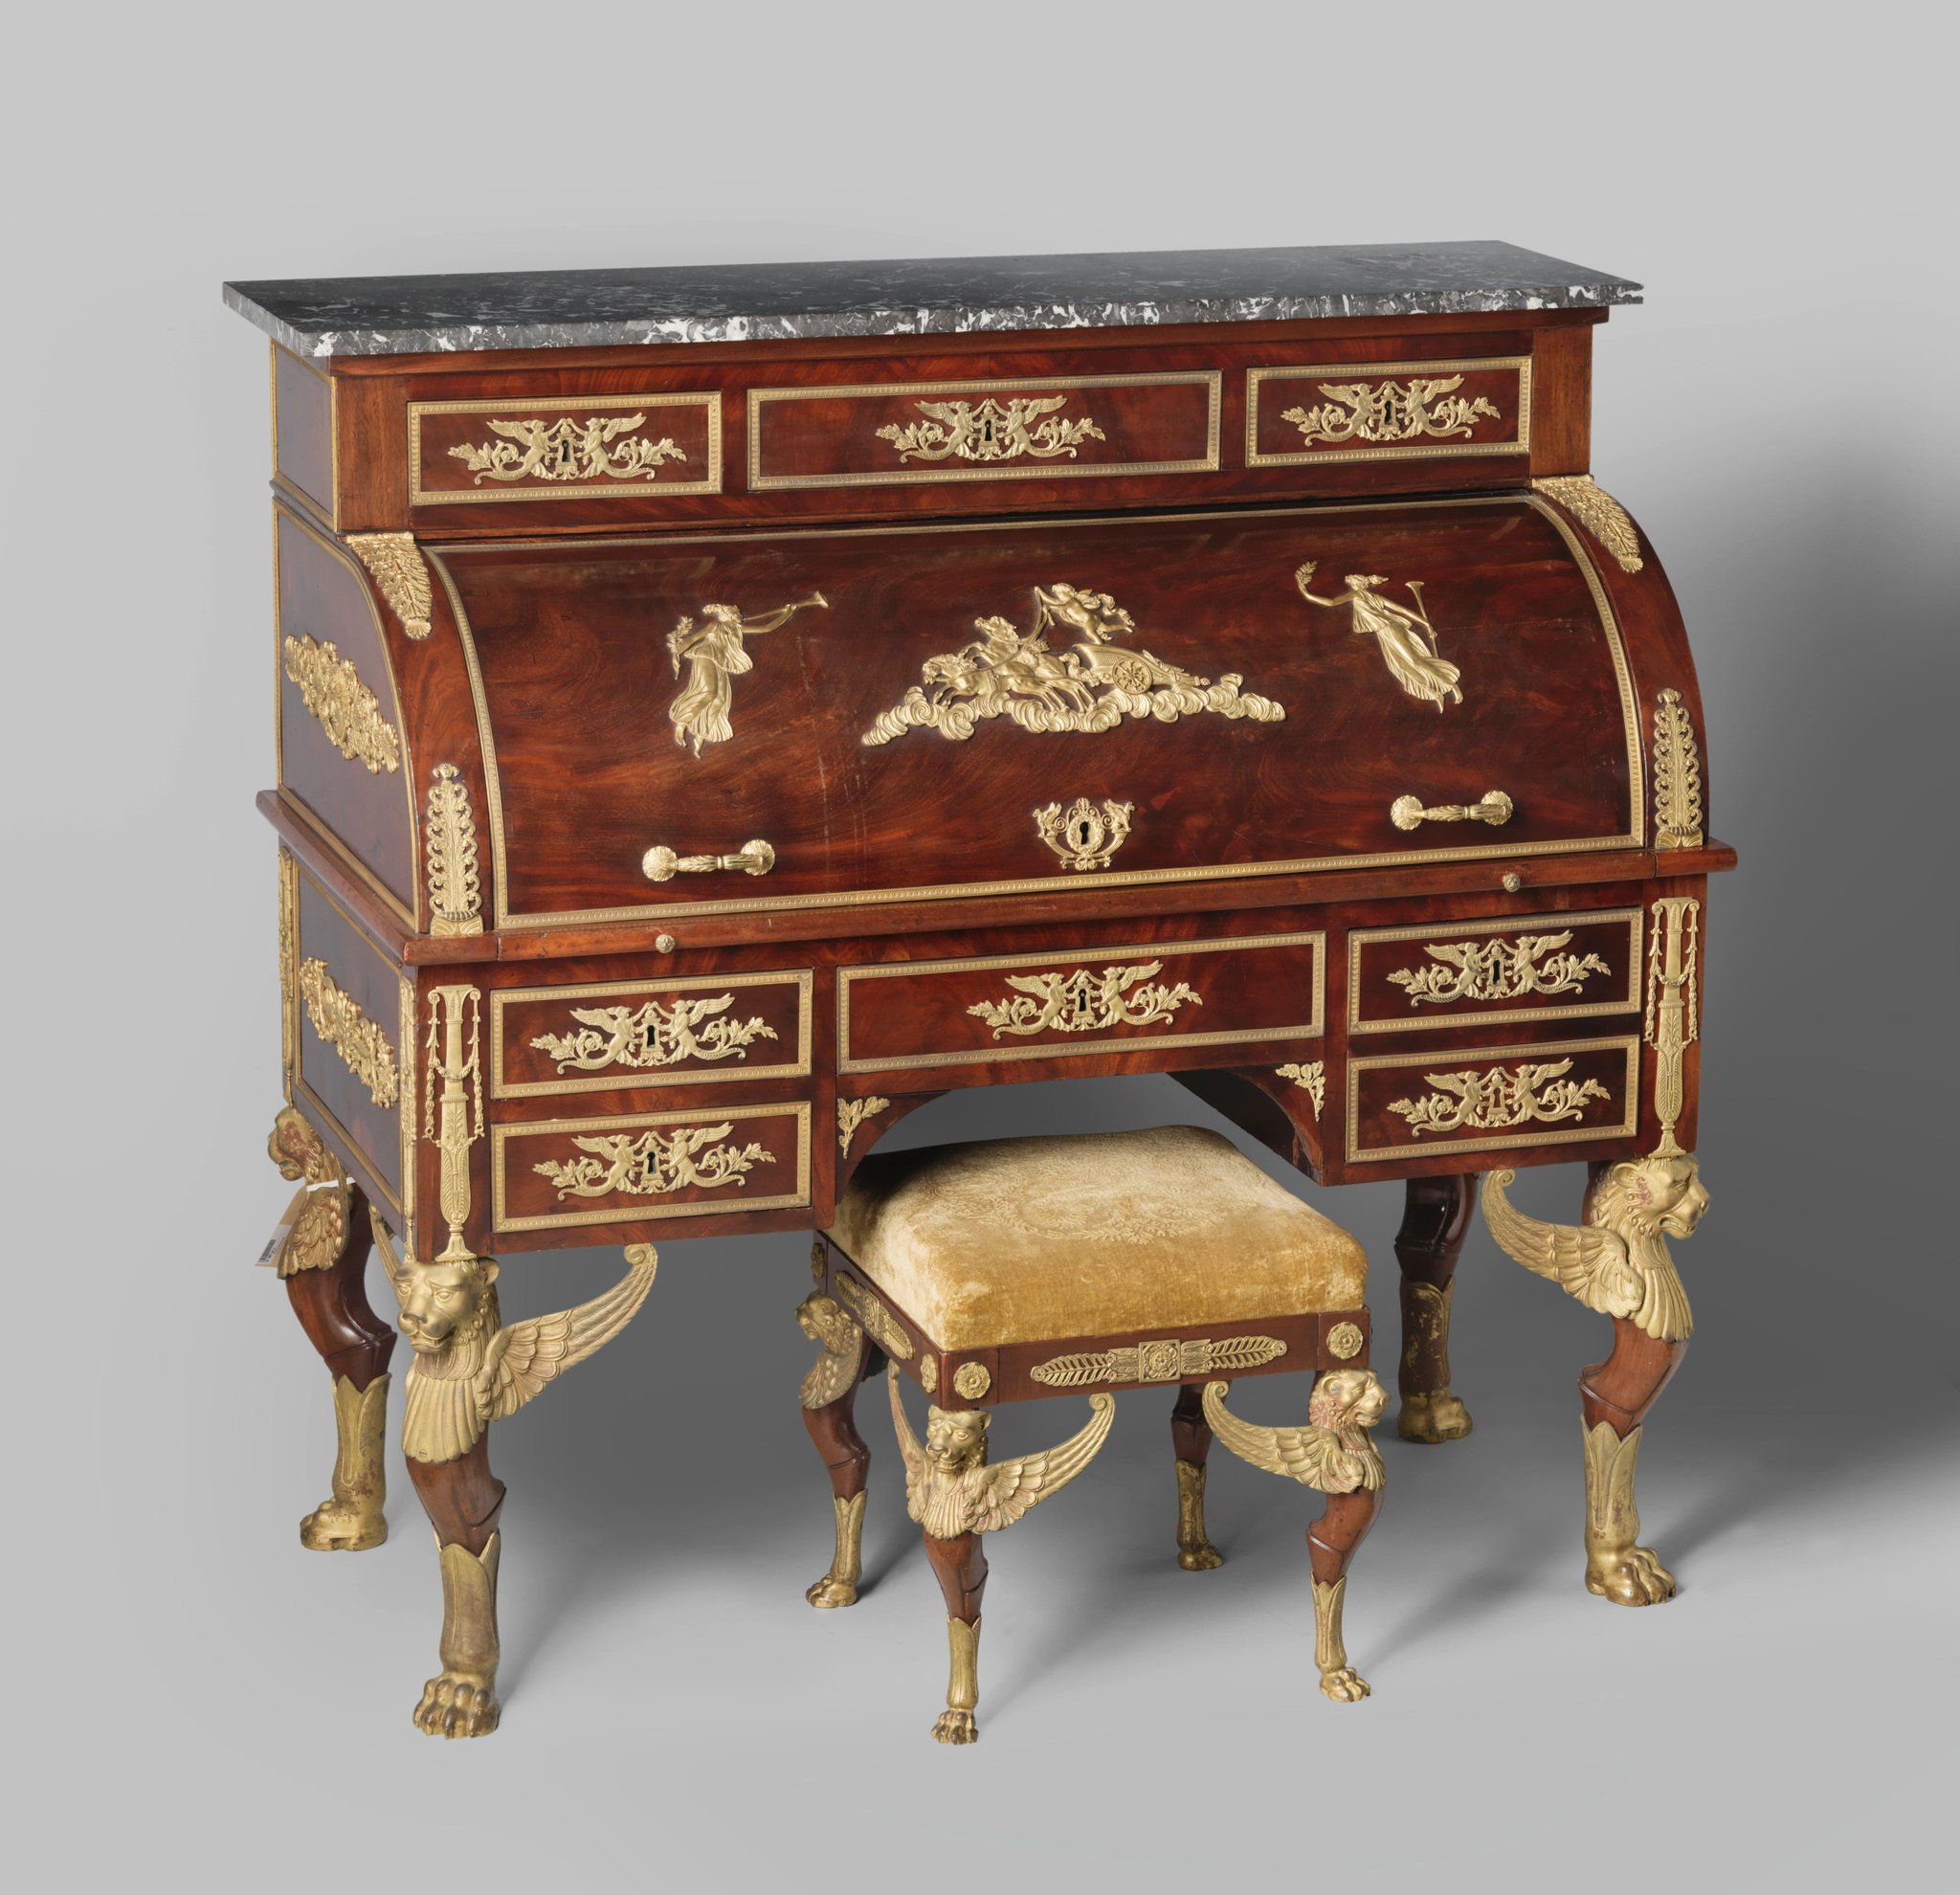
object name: desk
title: Bureau belijmd met mahoniehout en rustend op leeuwenpoten van brons die overgaan in gevleugelde leeuwenkoppen. Met laden, uitschuifbaar schrijfblad, klep en blad van marmer.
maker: jacob (meubelmaker)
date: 1836-1847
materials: bronze, leather, wood, marble, velvet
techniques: gilding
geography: paris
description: Bureau belijmd met mahoniehout, rustend op bronzen leeuwenpoten, die overgaan in bronzen gevleugelde leeuwenkoppen. Het bureau bevat van onder naar boven twee maal twee zijladen en een middenlade, een uitschuifbaar schrijfblad, gebogen klep, drie laden en een marmeren dekblad; eenzelfde indeling aan de achterkant met schijnladen en een vlak middenveld. Het meubel is overdadig versierd met verguld bronzen handgrepen, knoppen, sierranden en beslag en sleutelplaten met classicistische motieven.